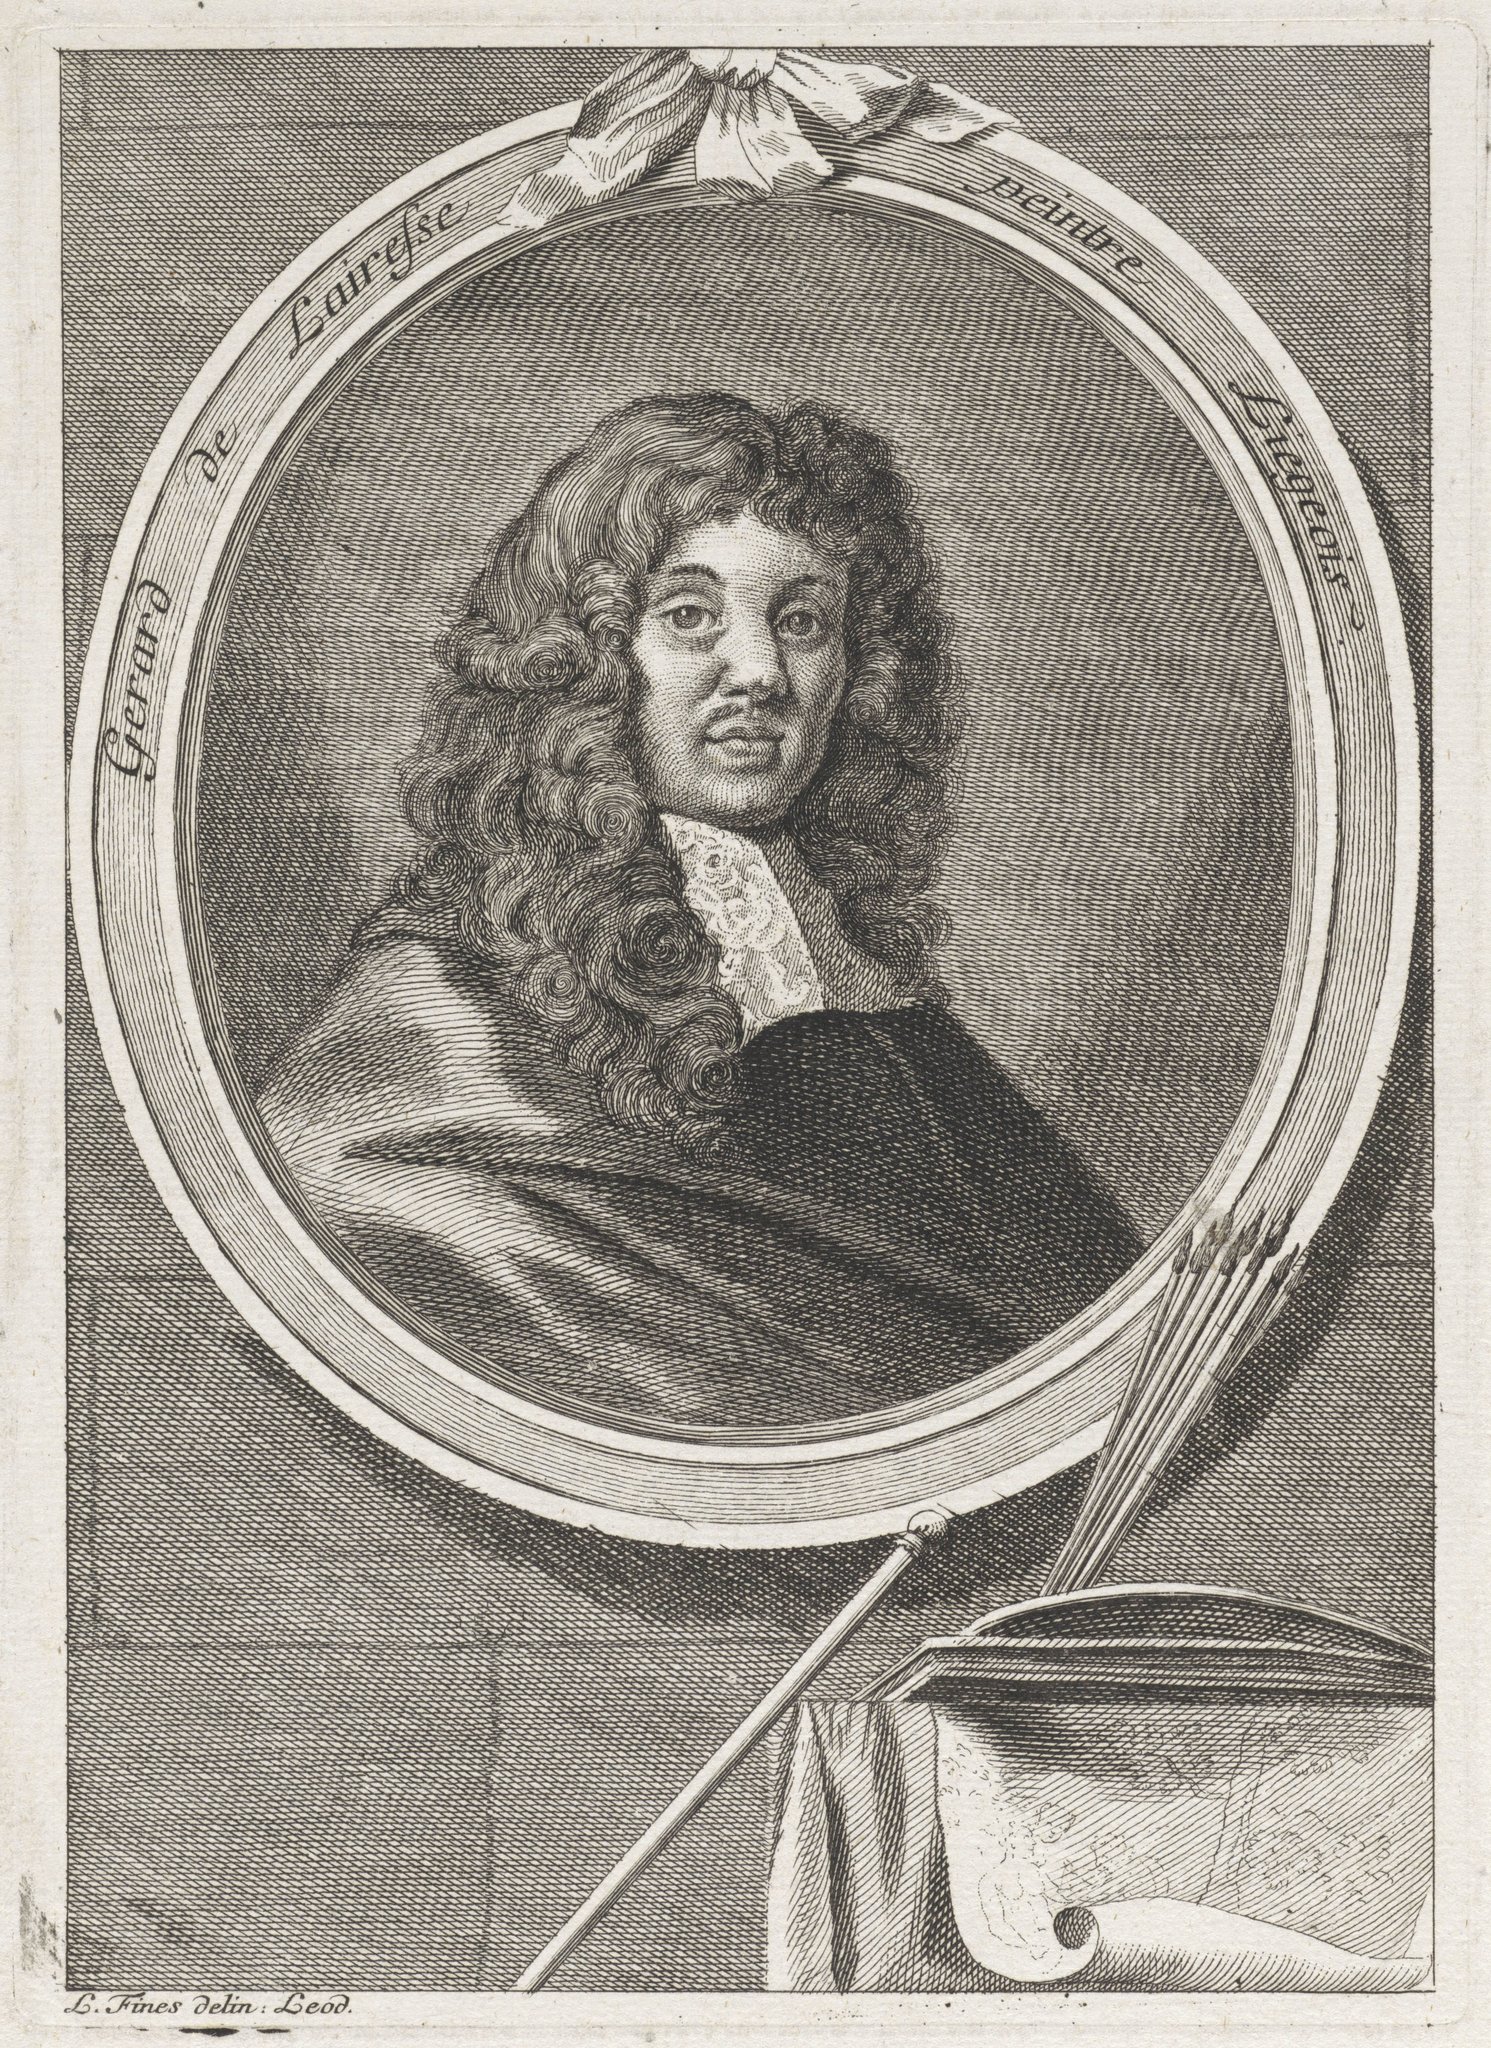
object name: print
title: Gerard de Lairesse peintre Liegeois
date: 1655-1689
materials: paper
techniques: engraving, etching, roulette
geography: liège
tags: liège, amsterdam, painter, print maker, draughtsman, gerard de lairesse, tools, implements of painter, portrait, self-portrait of artist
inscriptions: collector's mark: Lugt 2228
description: Portret van de kunstenaar Gerard de Lairesse. De ovale omlijsting is versierd met een strik. Onder de lijst liggen enkele schildersbenodigdheden, onder andere een schildersstok en enkele penselen.